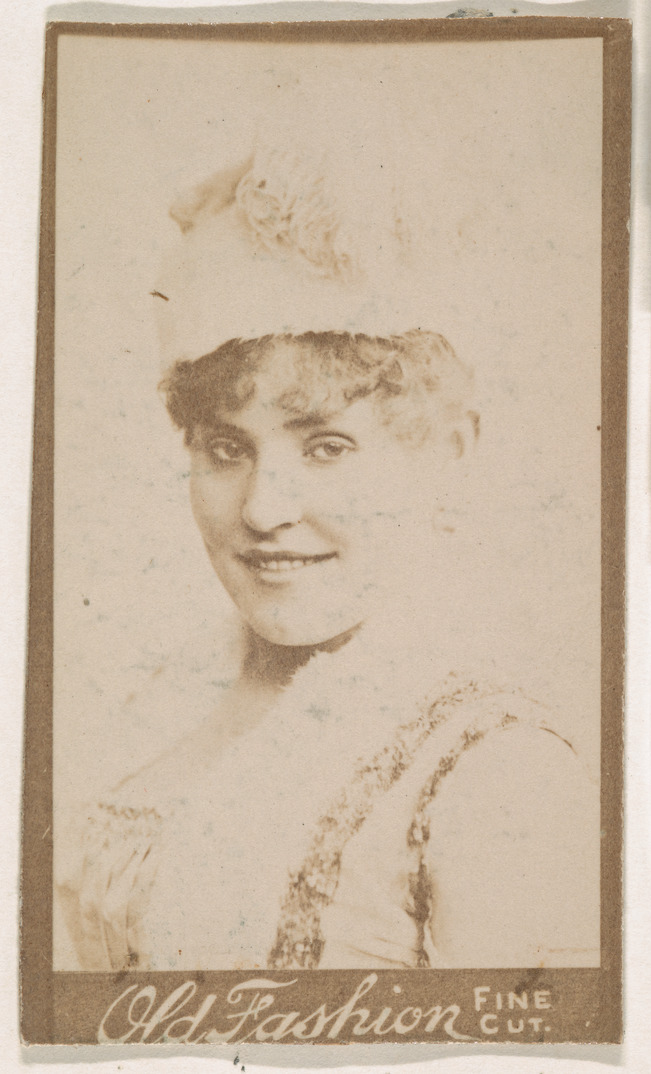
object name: photograph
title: Actress wearing feathered hat, from the Actresses series (N664) promoting Old Fashion Fine Cut Tobacco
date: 1888-1890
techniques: albumen silver print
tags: portraits,women,actresses